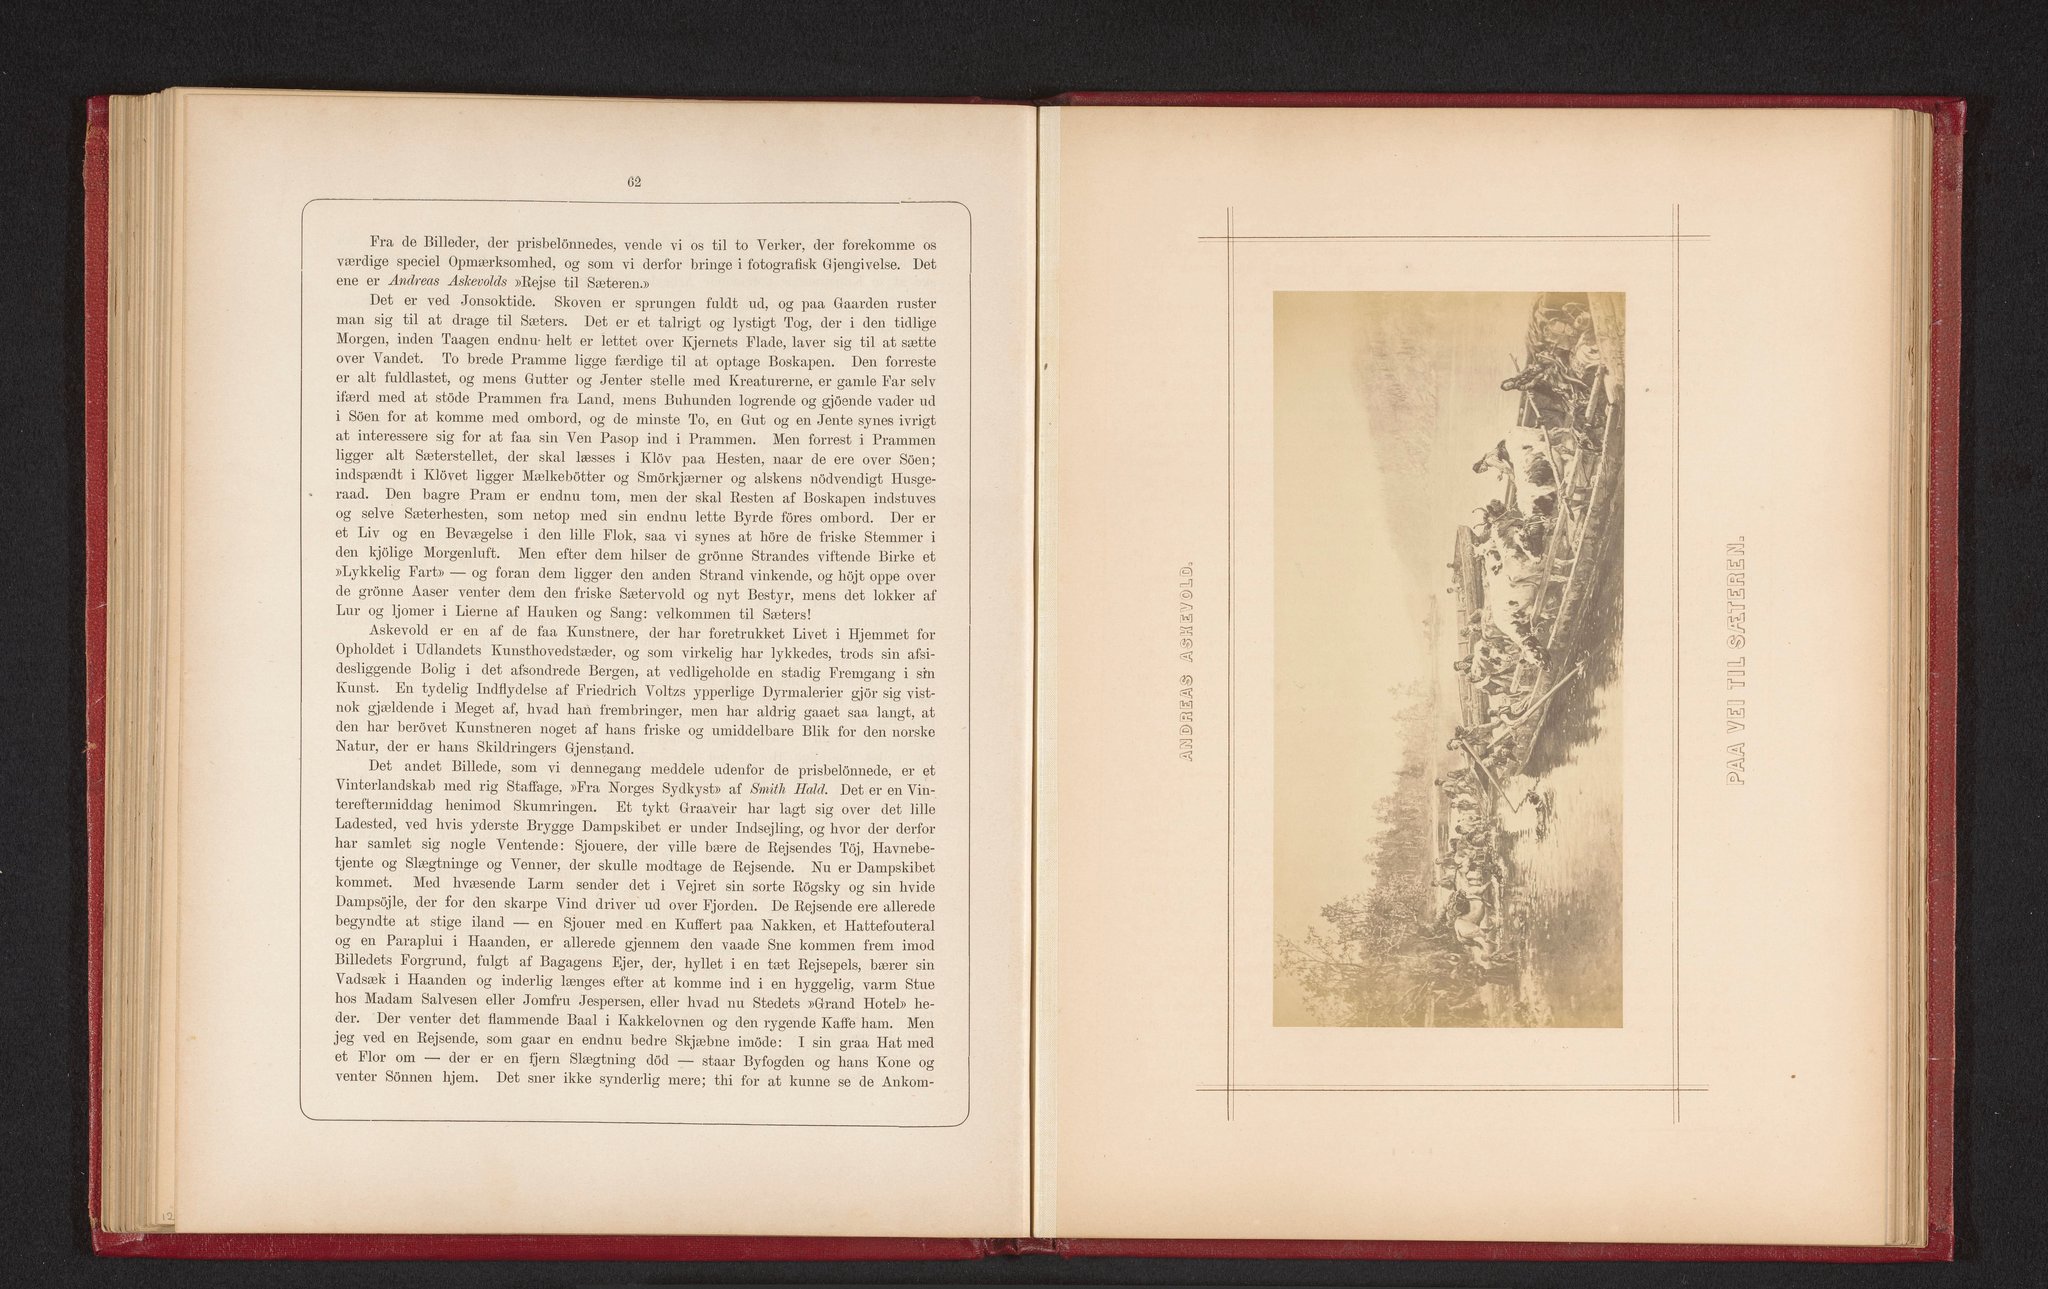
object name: reproduction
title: Paa Vei Til Sæteren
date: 1874-1879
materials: photographic support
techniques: albumen print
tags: bovine cattle, boat propelled by man or animal